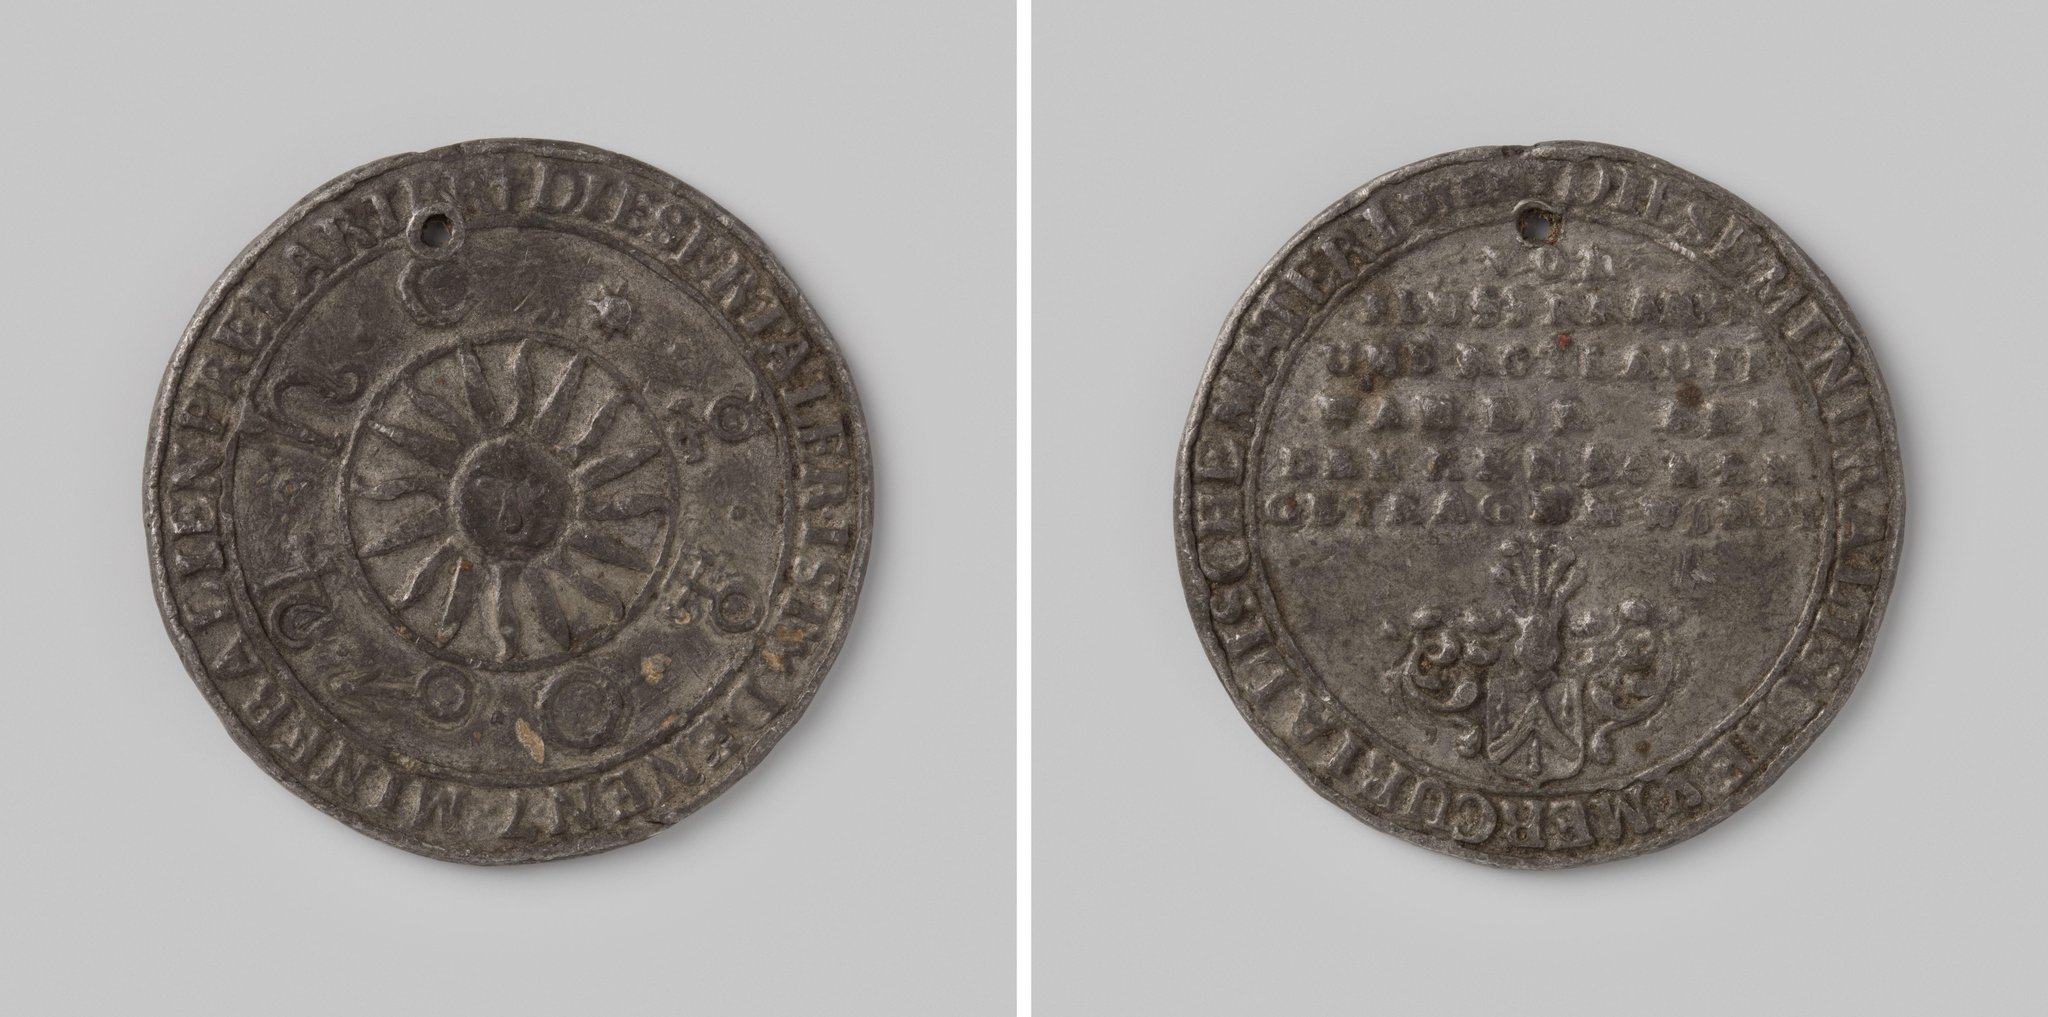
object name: history medal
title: Duits alchemisch geneeskrachtig amulet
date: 1600-1700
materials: lead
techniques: casting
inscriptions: circumscription: ‘DIESER TALER IST V DENEN 7 MINERALIEN PREPARIERT’, inscription: ‘VON / FLÜSS KRAMPF / UND ROTLAUFF / WAN ER BEY / DEN MENSCHEN / GETRAGEN WIRDT’, circumscription: ‘DIESE MINERALISCHE V MERCURIALISCHE MATERI DIENT’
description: Tinnen penning met doorboring, op de voorzijde een zon binnen een cirkel met alchemische symbolen, met omschrift, op de keerzijde zes regels tekst boven een klein gehelmd wapenschild, met omschrift